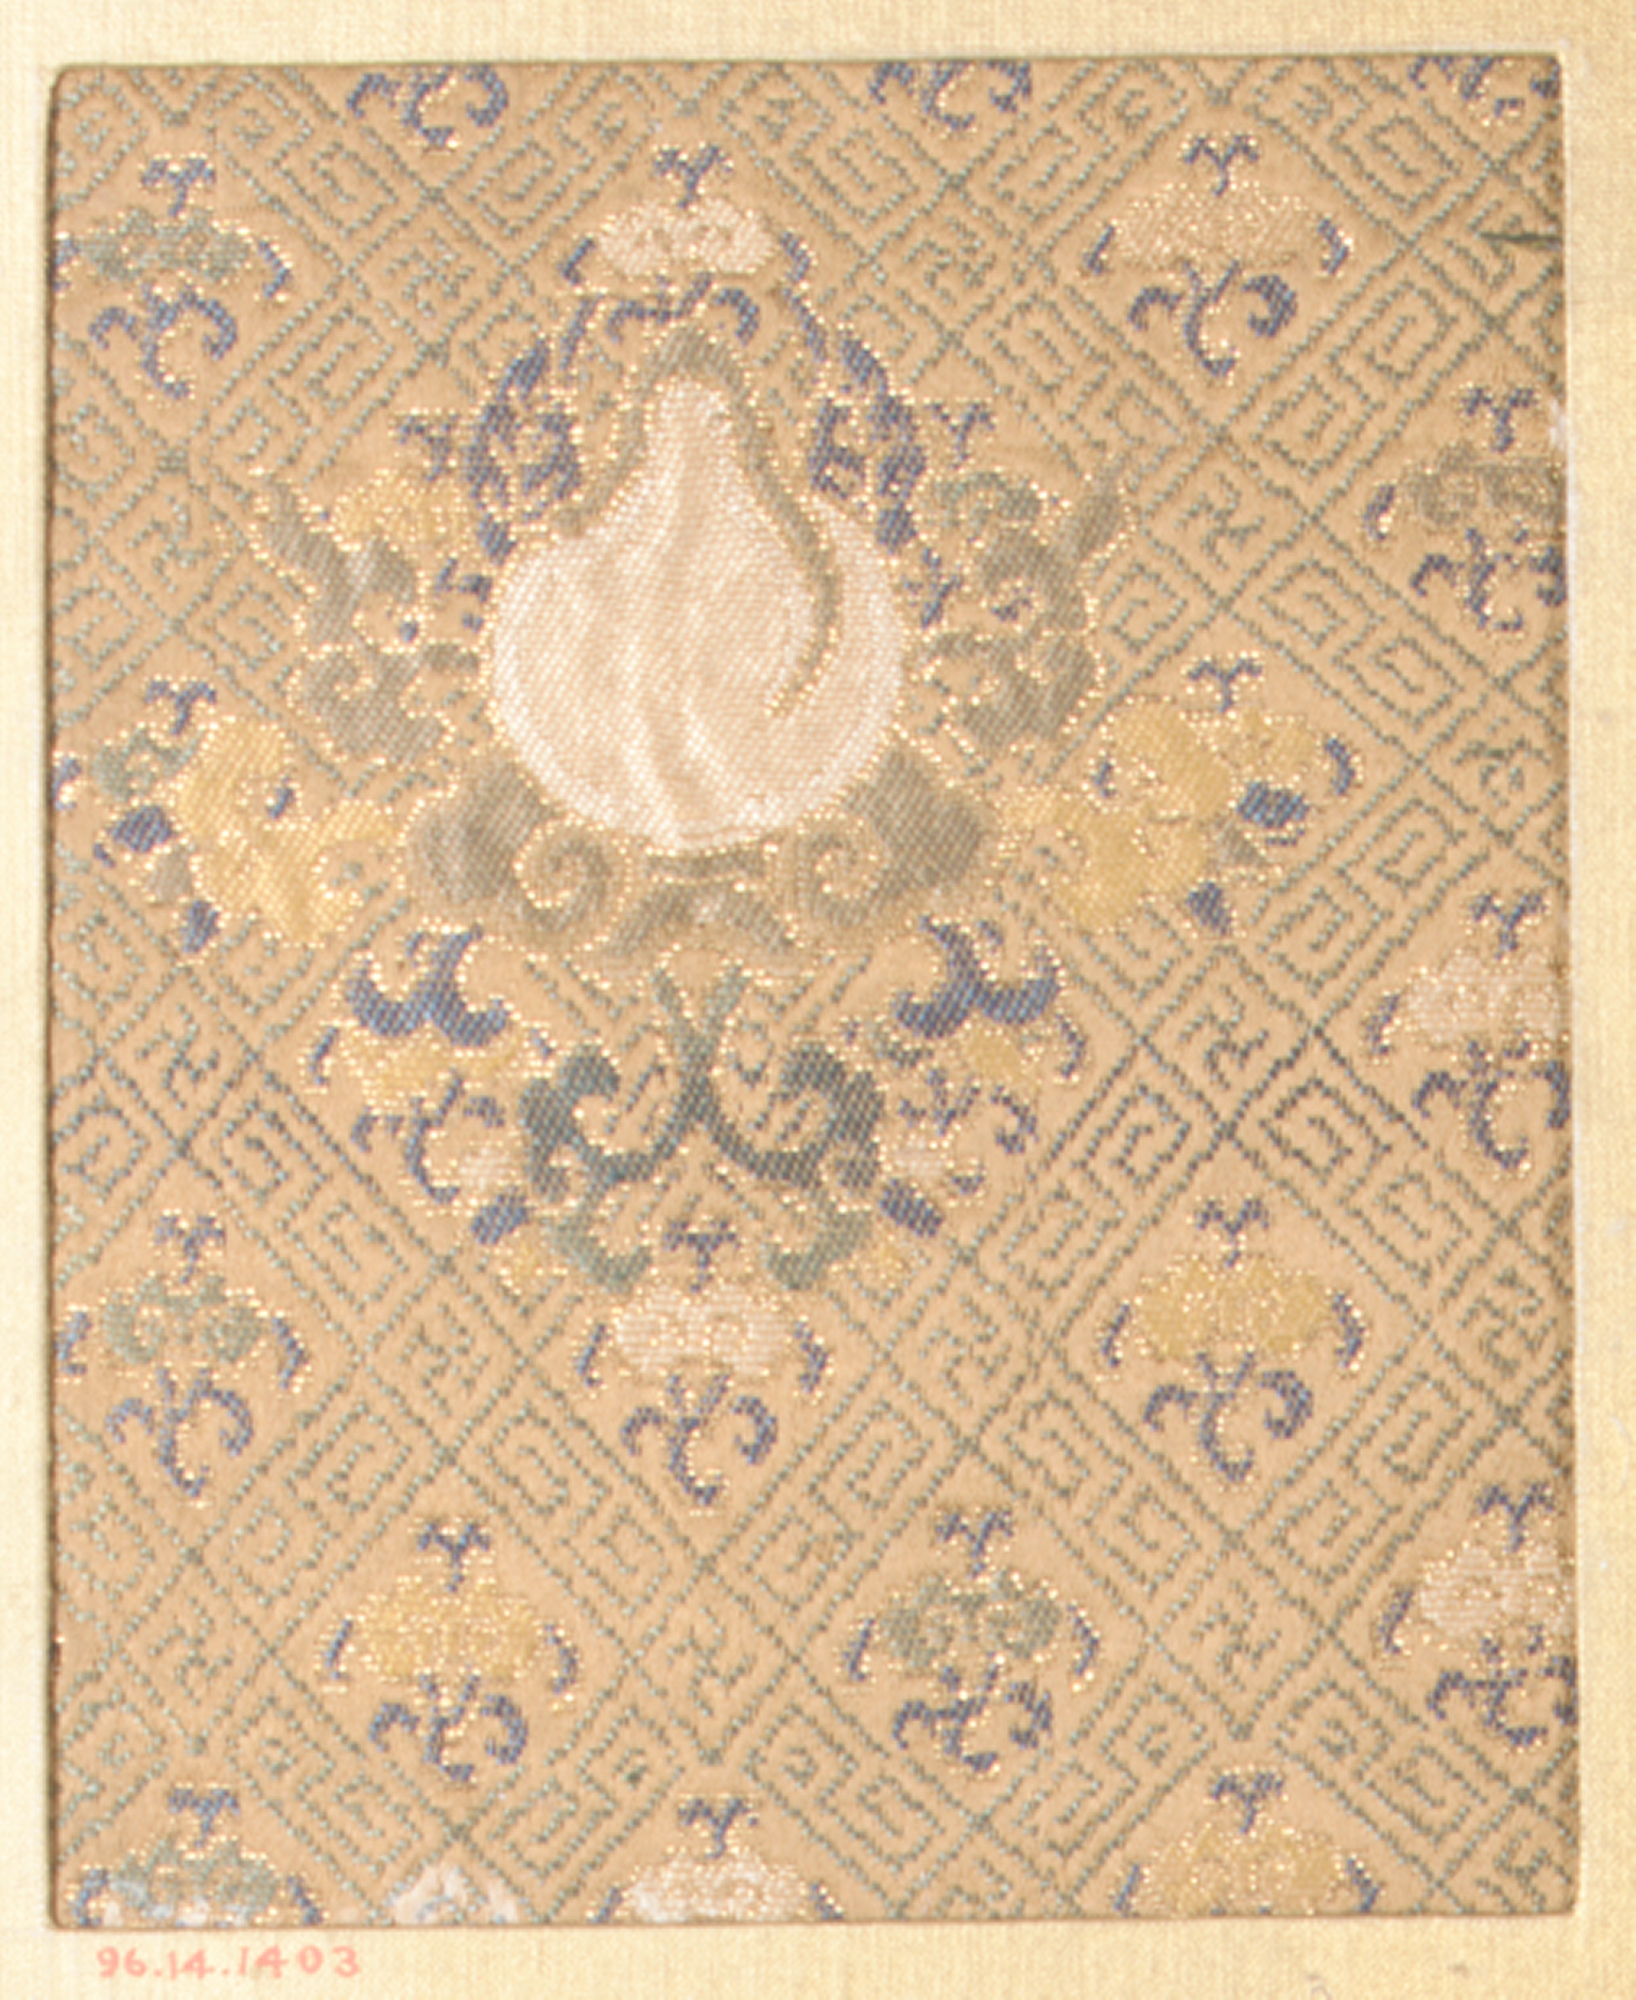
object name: piece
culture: japanese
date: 1701-1900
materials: silk